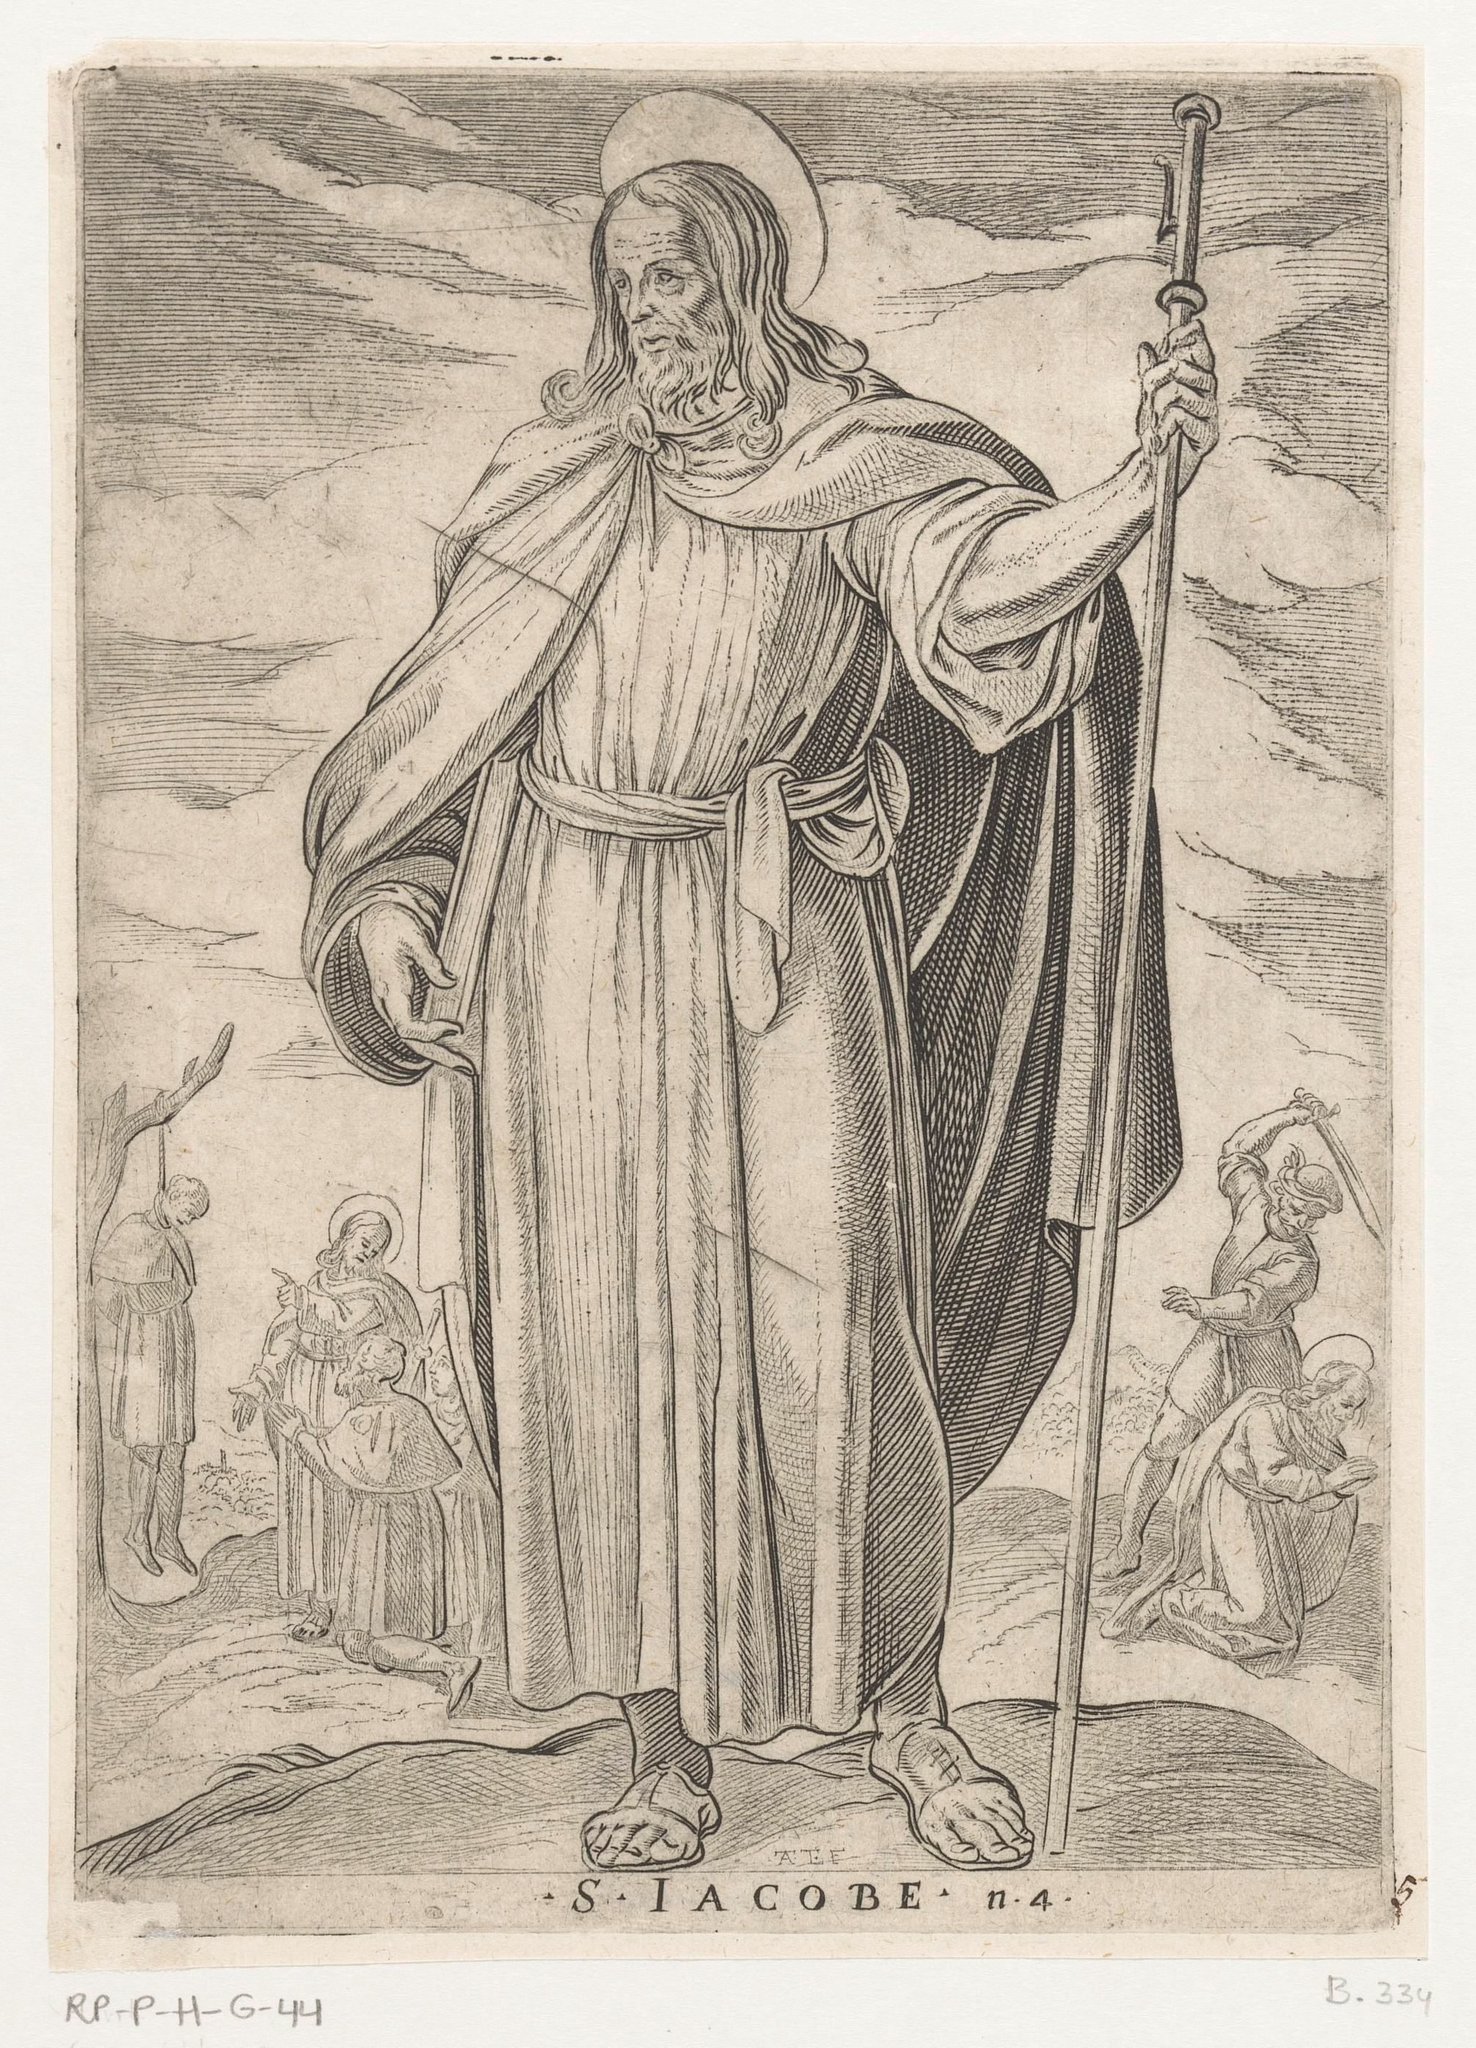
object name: print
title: S. Iacobe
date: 1565-1630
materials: paper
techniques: etching, intaglio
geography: italy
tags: the apostle james the great; possible attributes: book, pilgrim's cloak, hat, shell, staff, and wallet, scroll, sword - miraculous activities and events ~ male saint, martyrdom and death of james, the apostle james the great; possible attributes: book, pilgrim's cloak, hat, shell, staff, and wallet, scroll, sword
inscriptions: collector's mark: ‘Hinloopen’, collector's mark: Lugt 11, number: ‘5’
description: De heilige Jakobus de Meerdere met pelgrimsstaf en boek. Op de achtergrond links wekt Jakobus de opgehangen zoon van een pelgrim weer tot leven. Op de achtergrond rechts wordt Jakobus onthoofd door een soldaat met een zwaard.